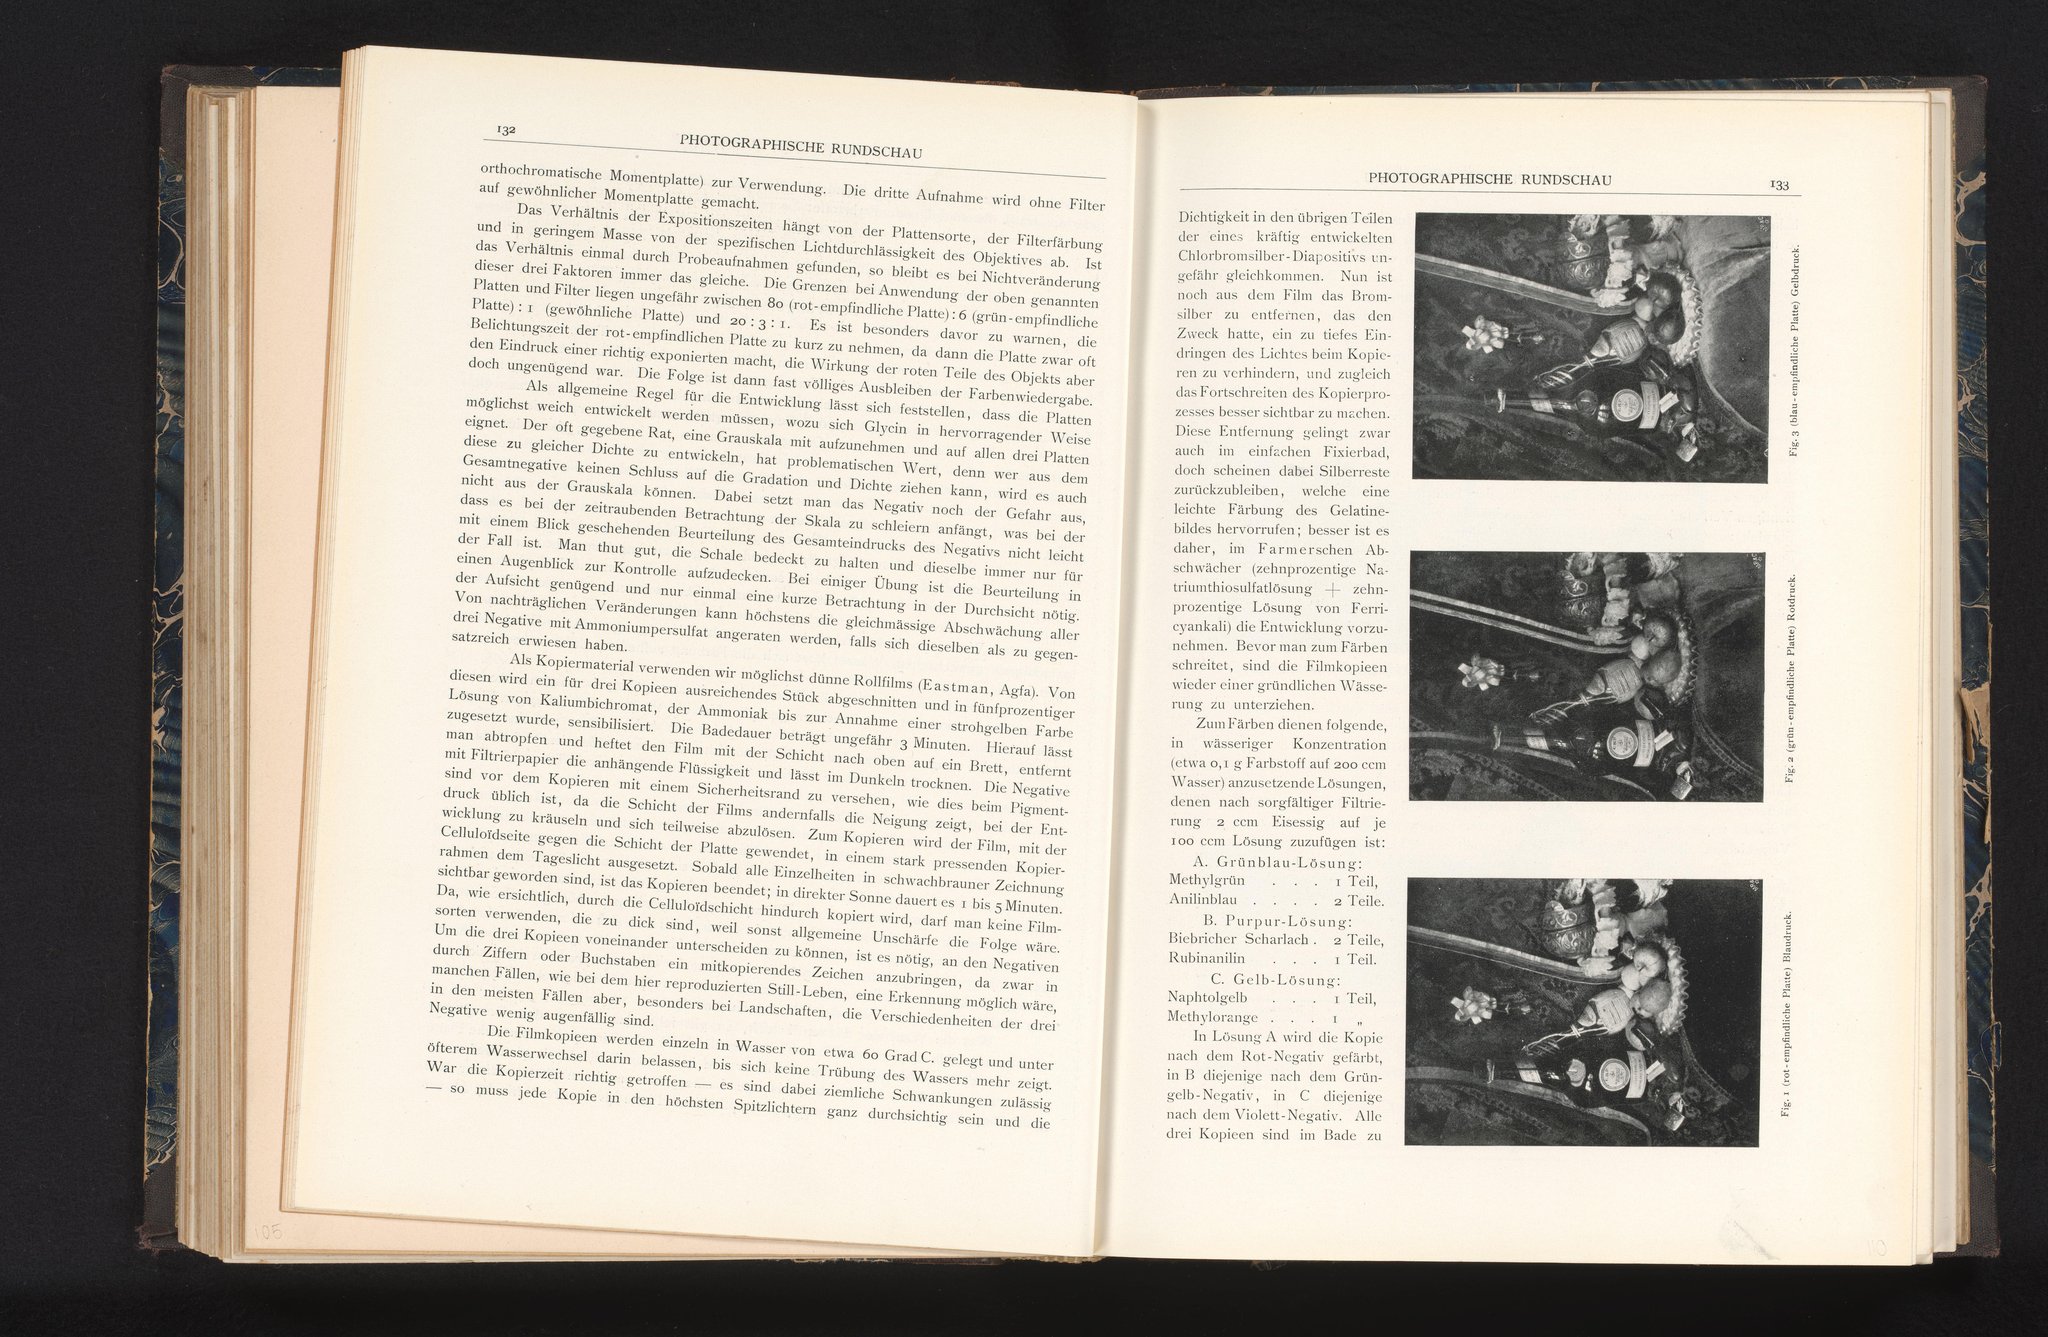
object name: page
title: Blaudruck, Rotdruk, Gelbdruck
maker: Anonymous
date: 1897-1902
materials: paper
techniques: autotype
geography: berlin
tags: still life of miscellaneous objects